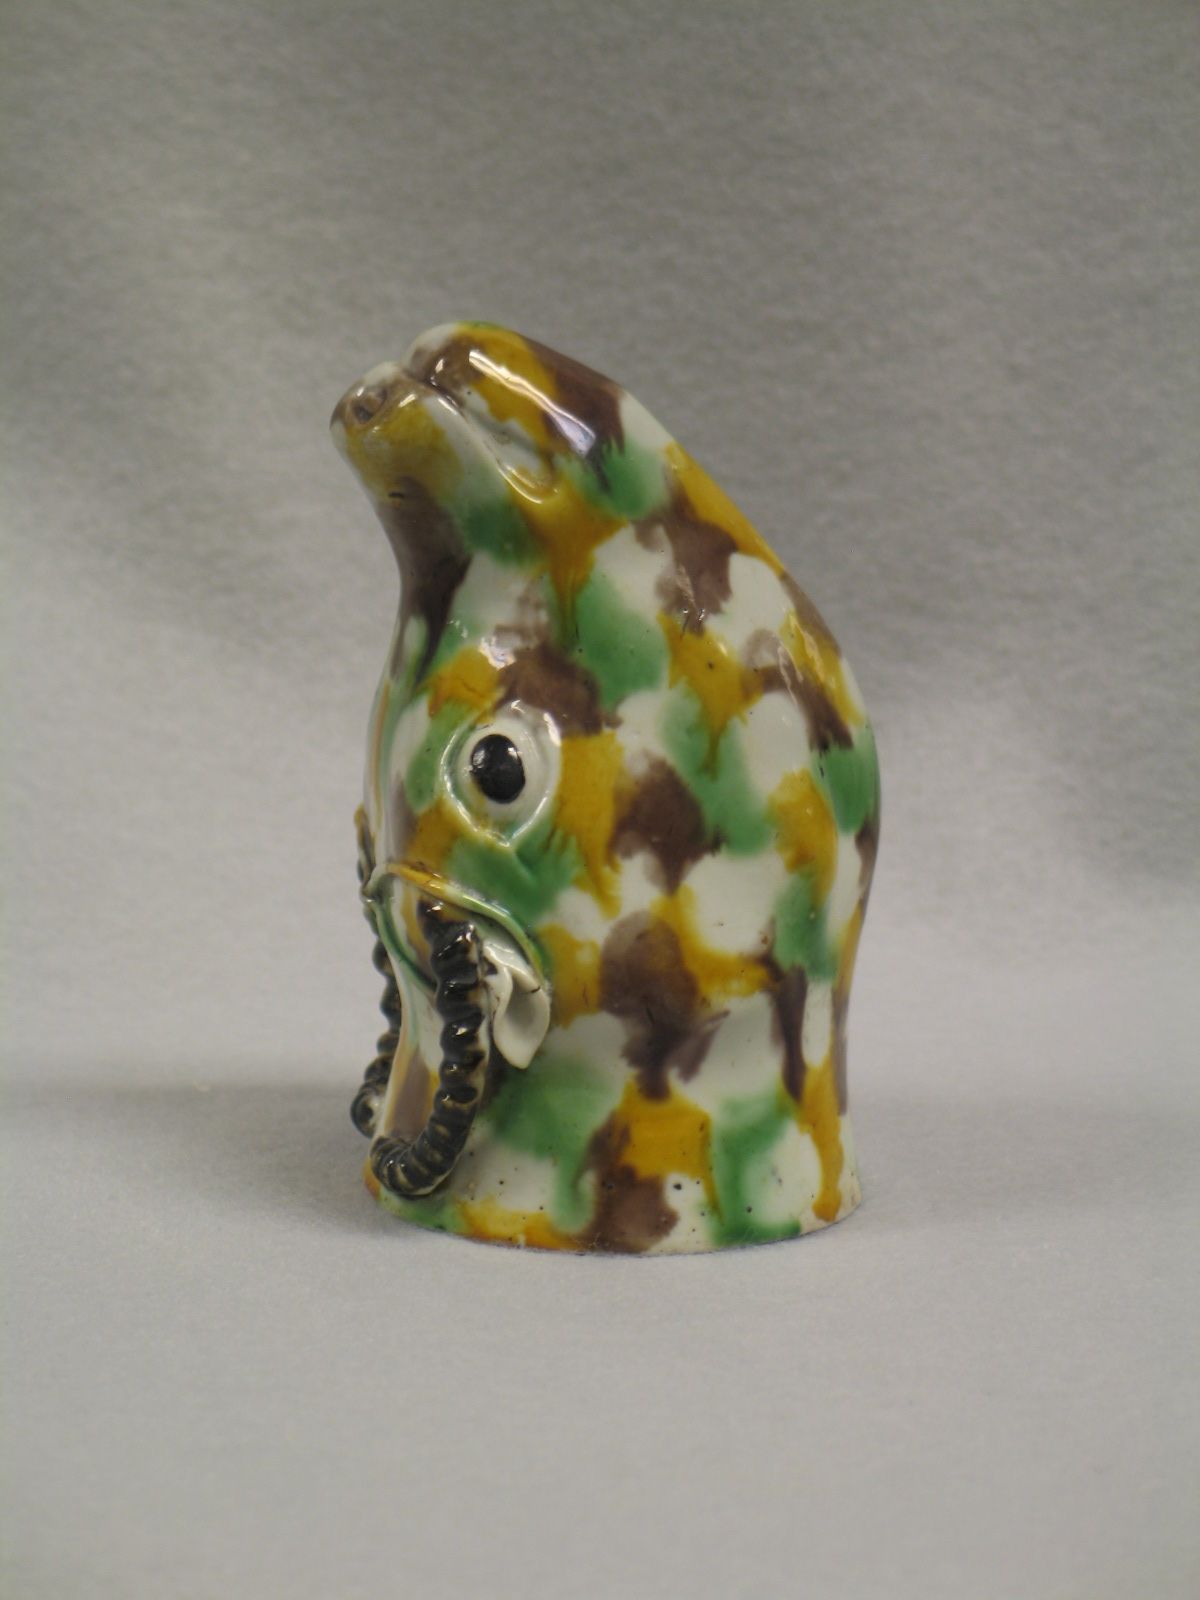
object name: cup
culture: chinese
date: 1644-1911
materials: porcelain